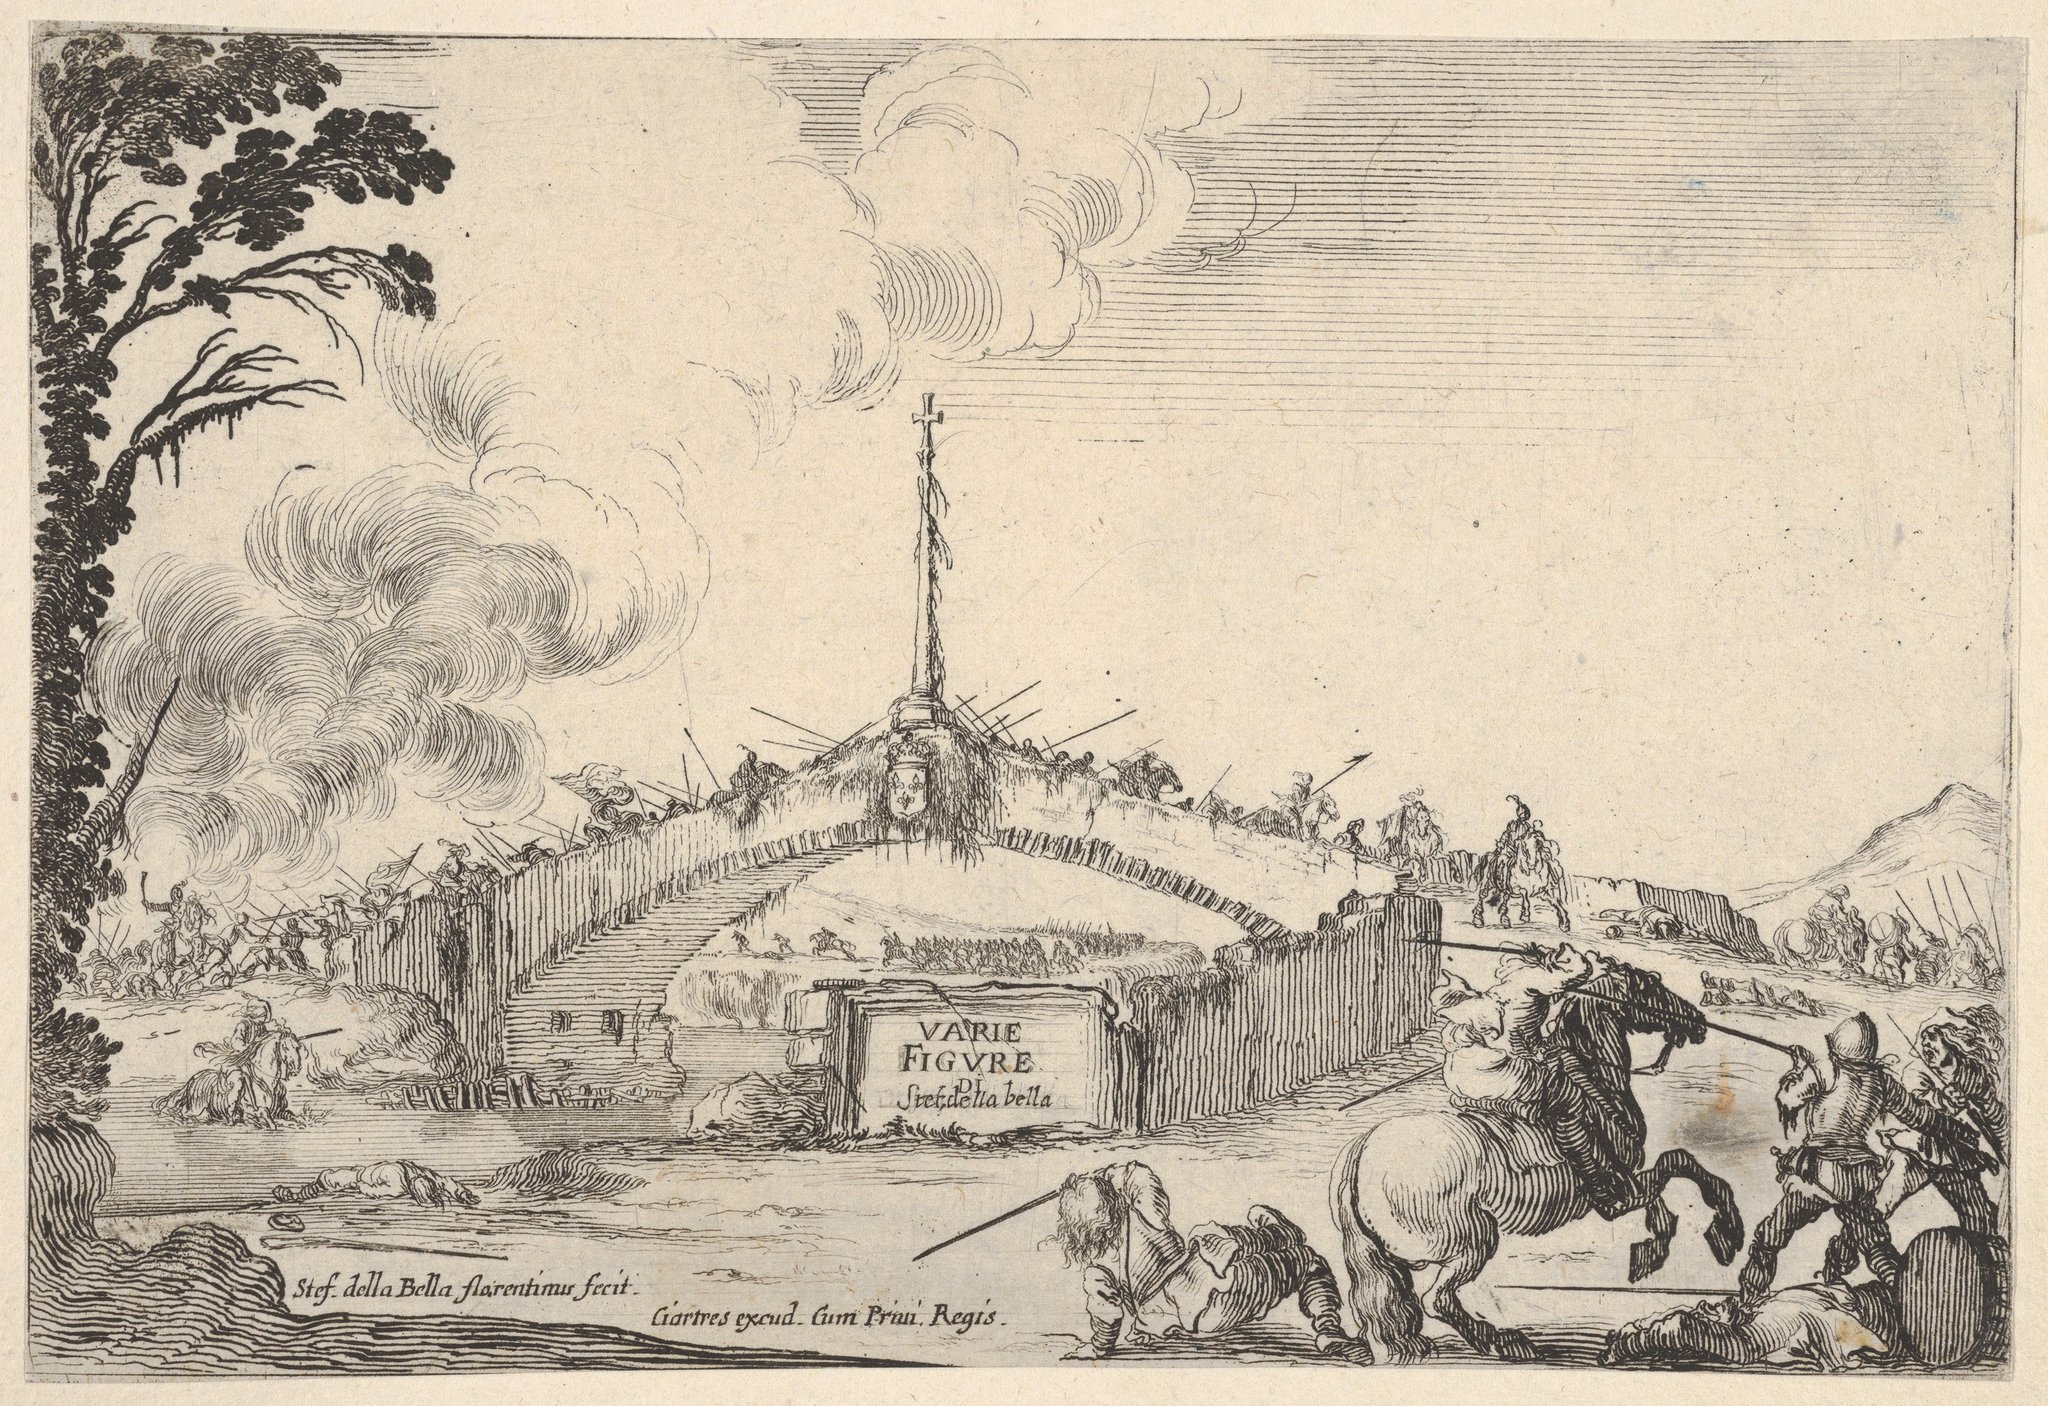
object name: print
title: Combat on a bridge, a horseman and two footsoldiers battle with swords at bottom right, one footsoldier on the ground to left of the horseman, various soldiers with swords on the bridge in the background, French coat of arms displayed in center of bridge, title page from "Varie Figure"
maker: stefano della bella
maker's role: artist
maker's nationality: italian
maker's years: 1610-1664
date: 1645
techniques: etching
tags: bridges,battles,soldiers,horses,coat of arms